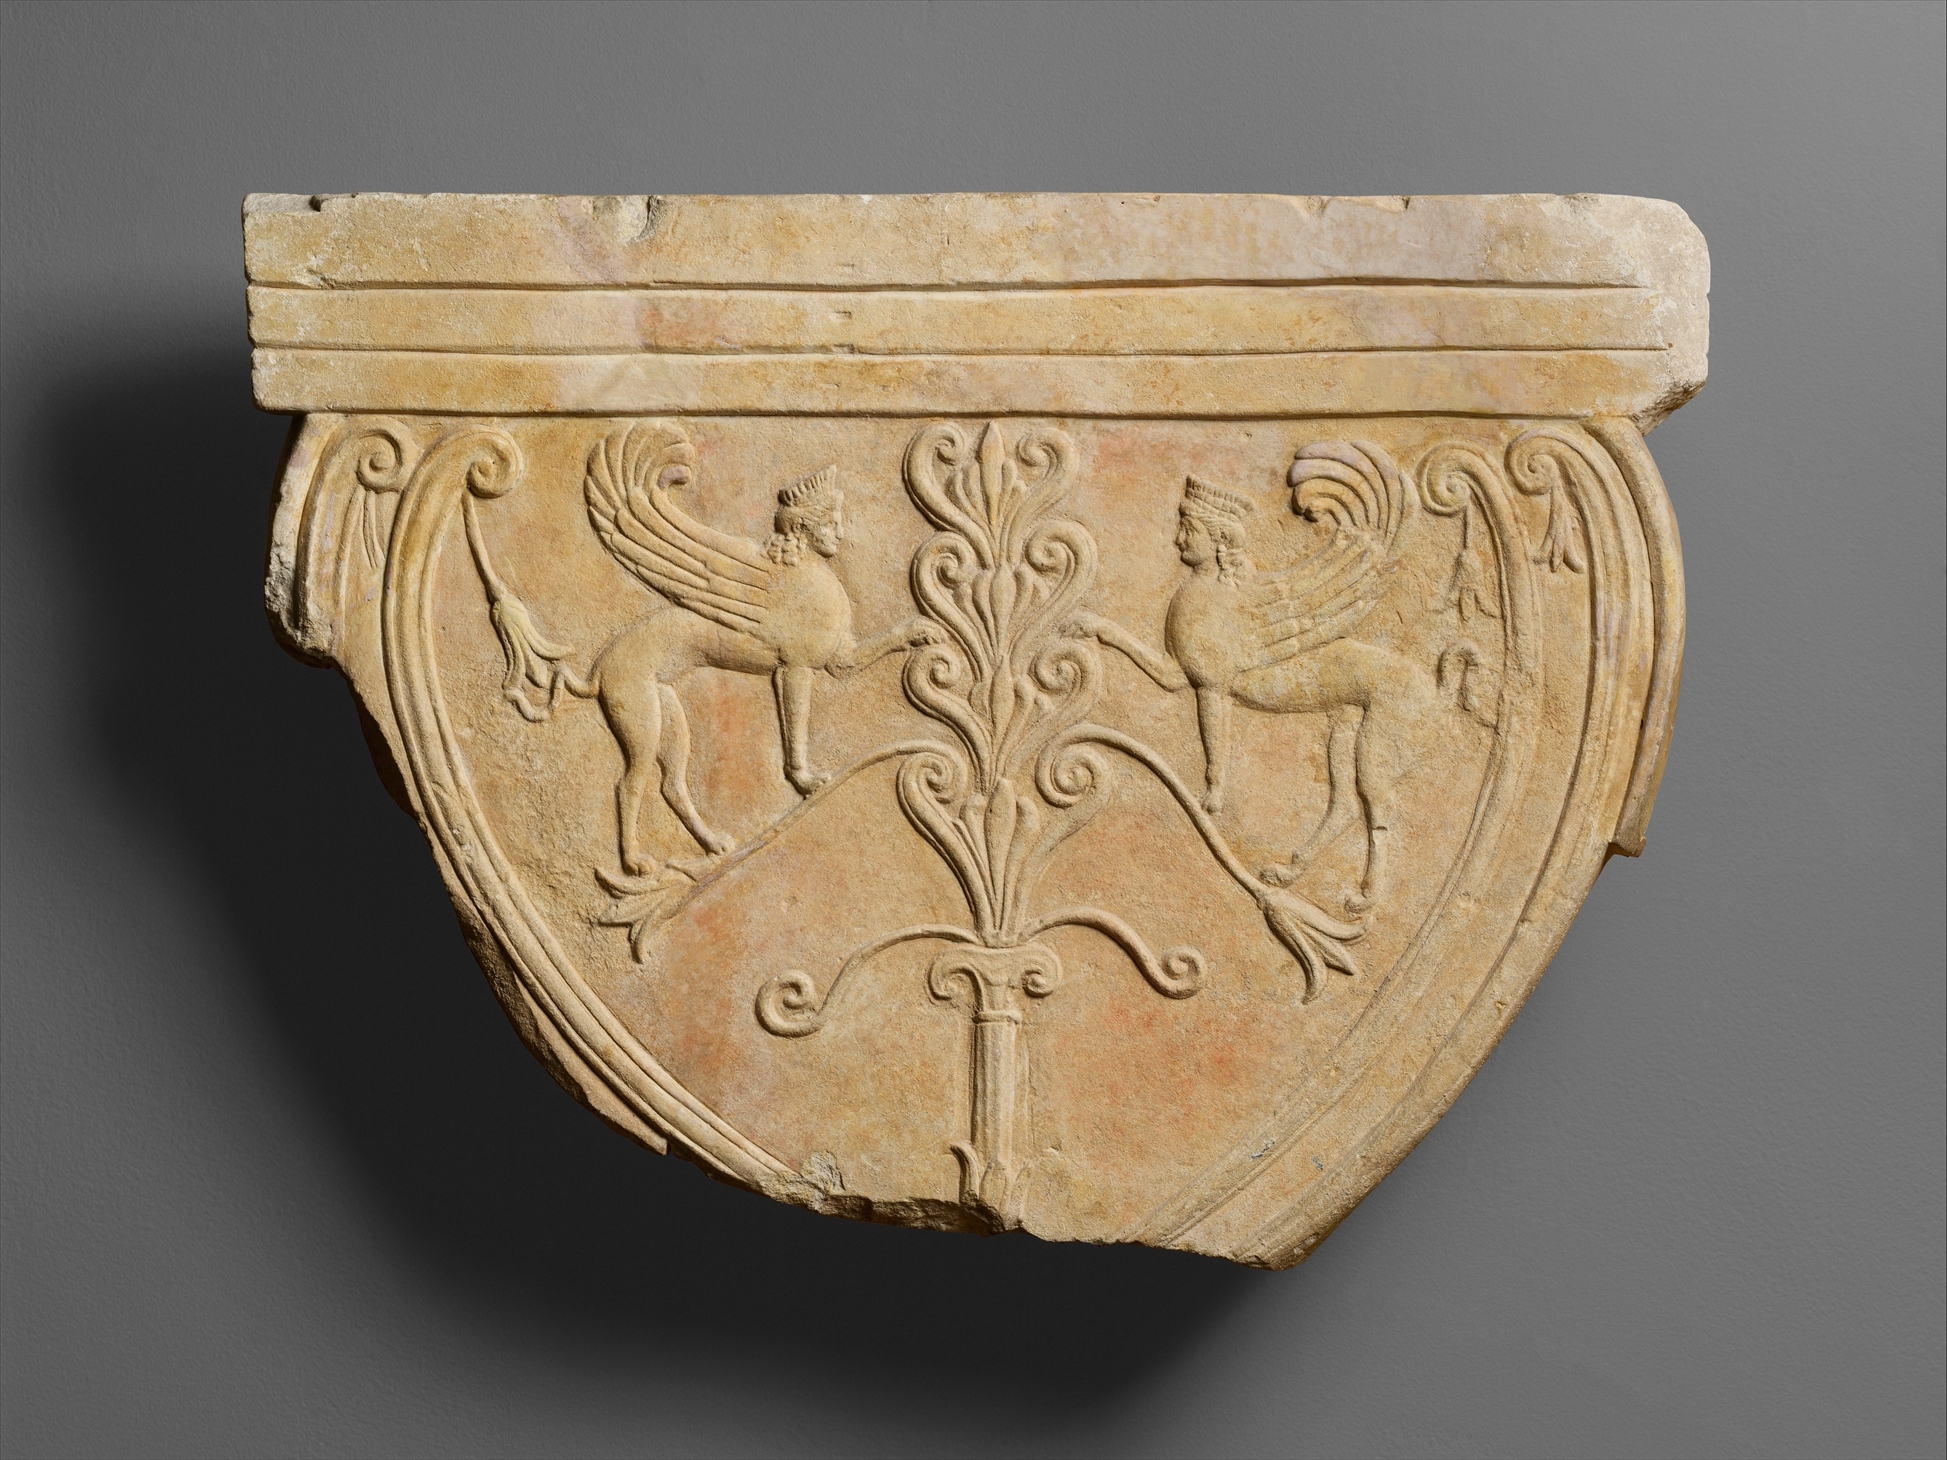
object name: capital of a stele with sphinx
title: Fragmentary limestone Cypriot capital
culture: cypriot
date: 500-401 BCE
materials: limestone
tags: sphinx